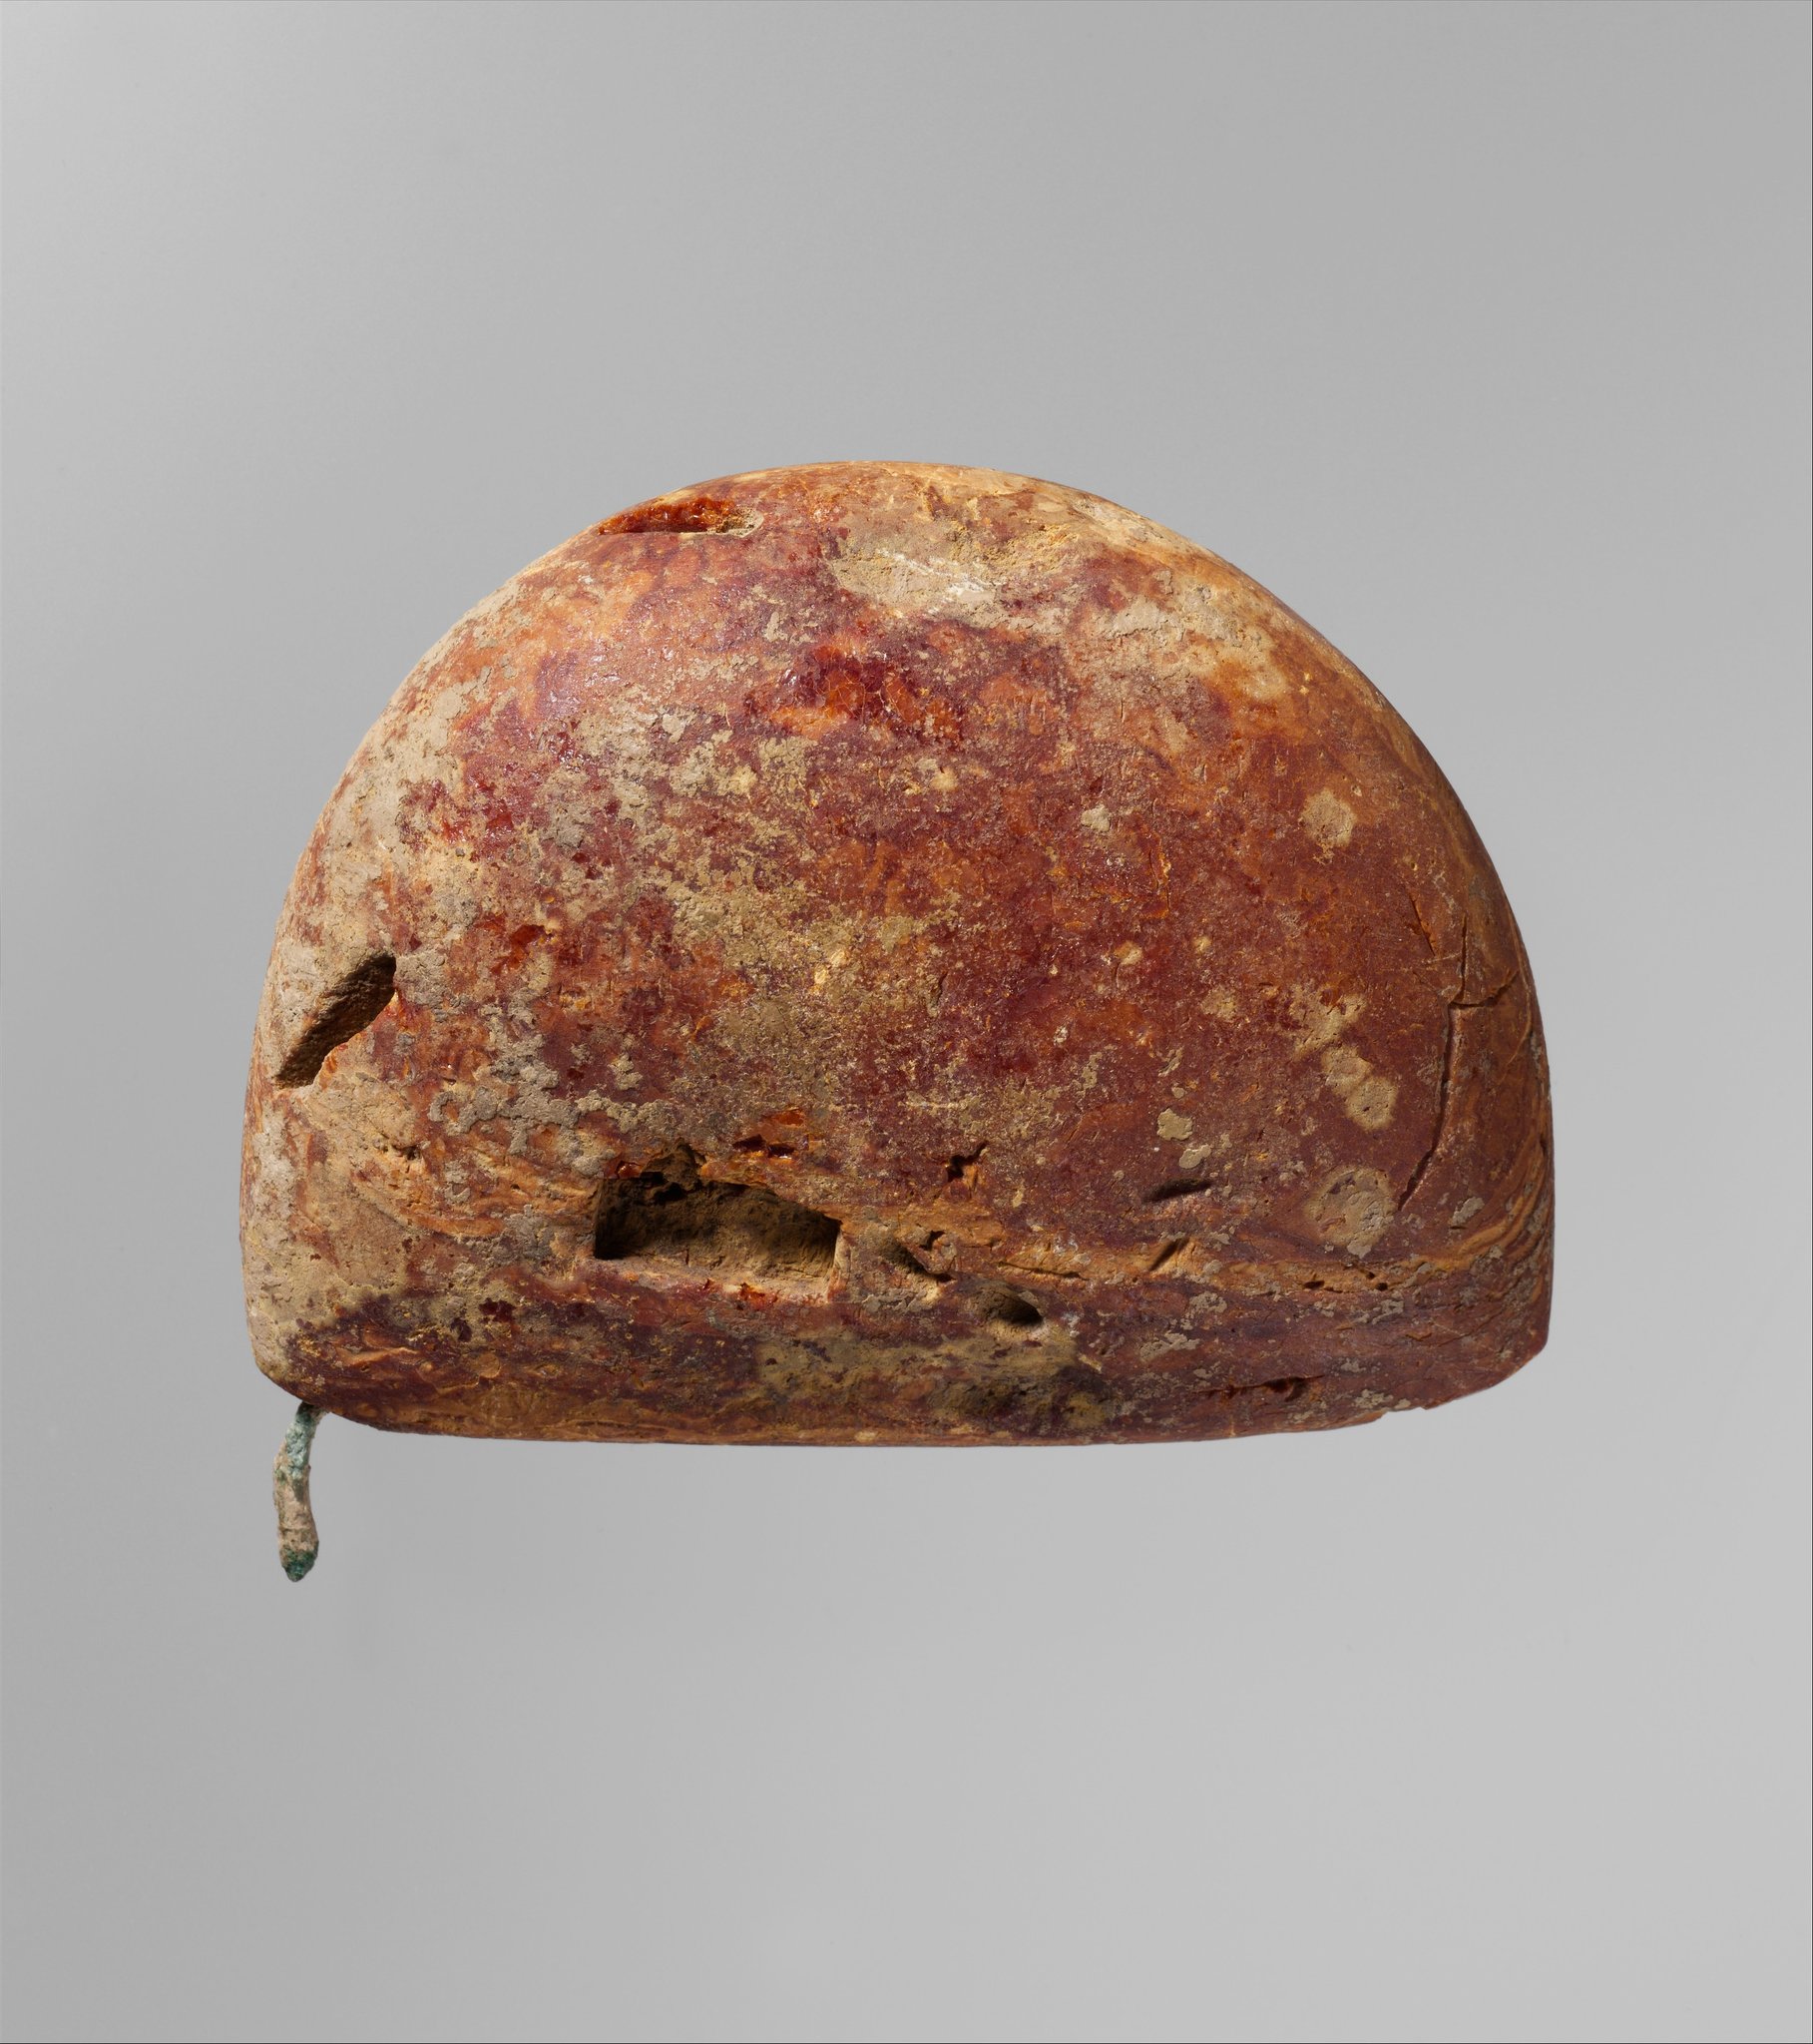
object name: fibula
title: Bronze and amber fibula (safety pin)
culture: etruscan or italic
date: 700-601 BCE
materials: amber